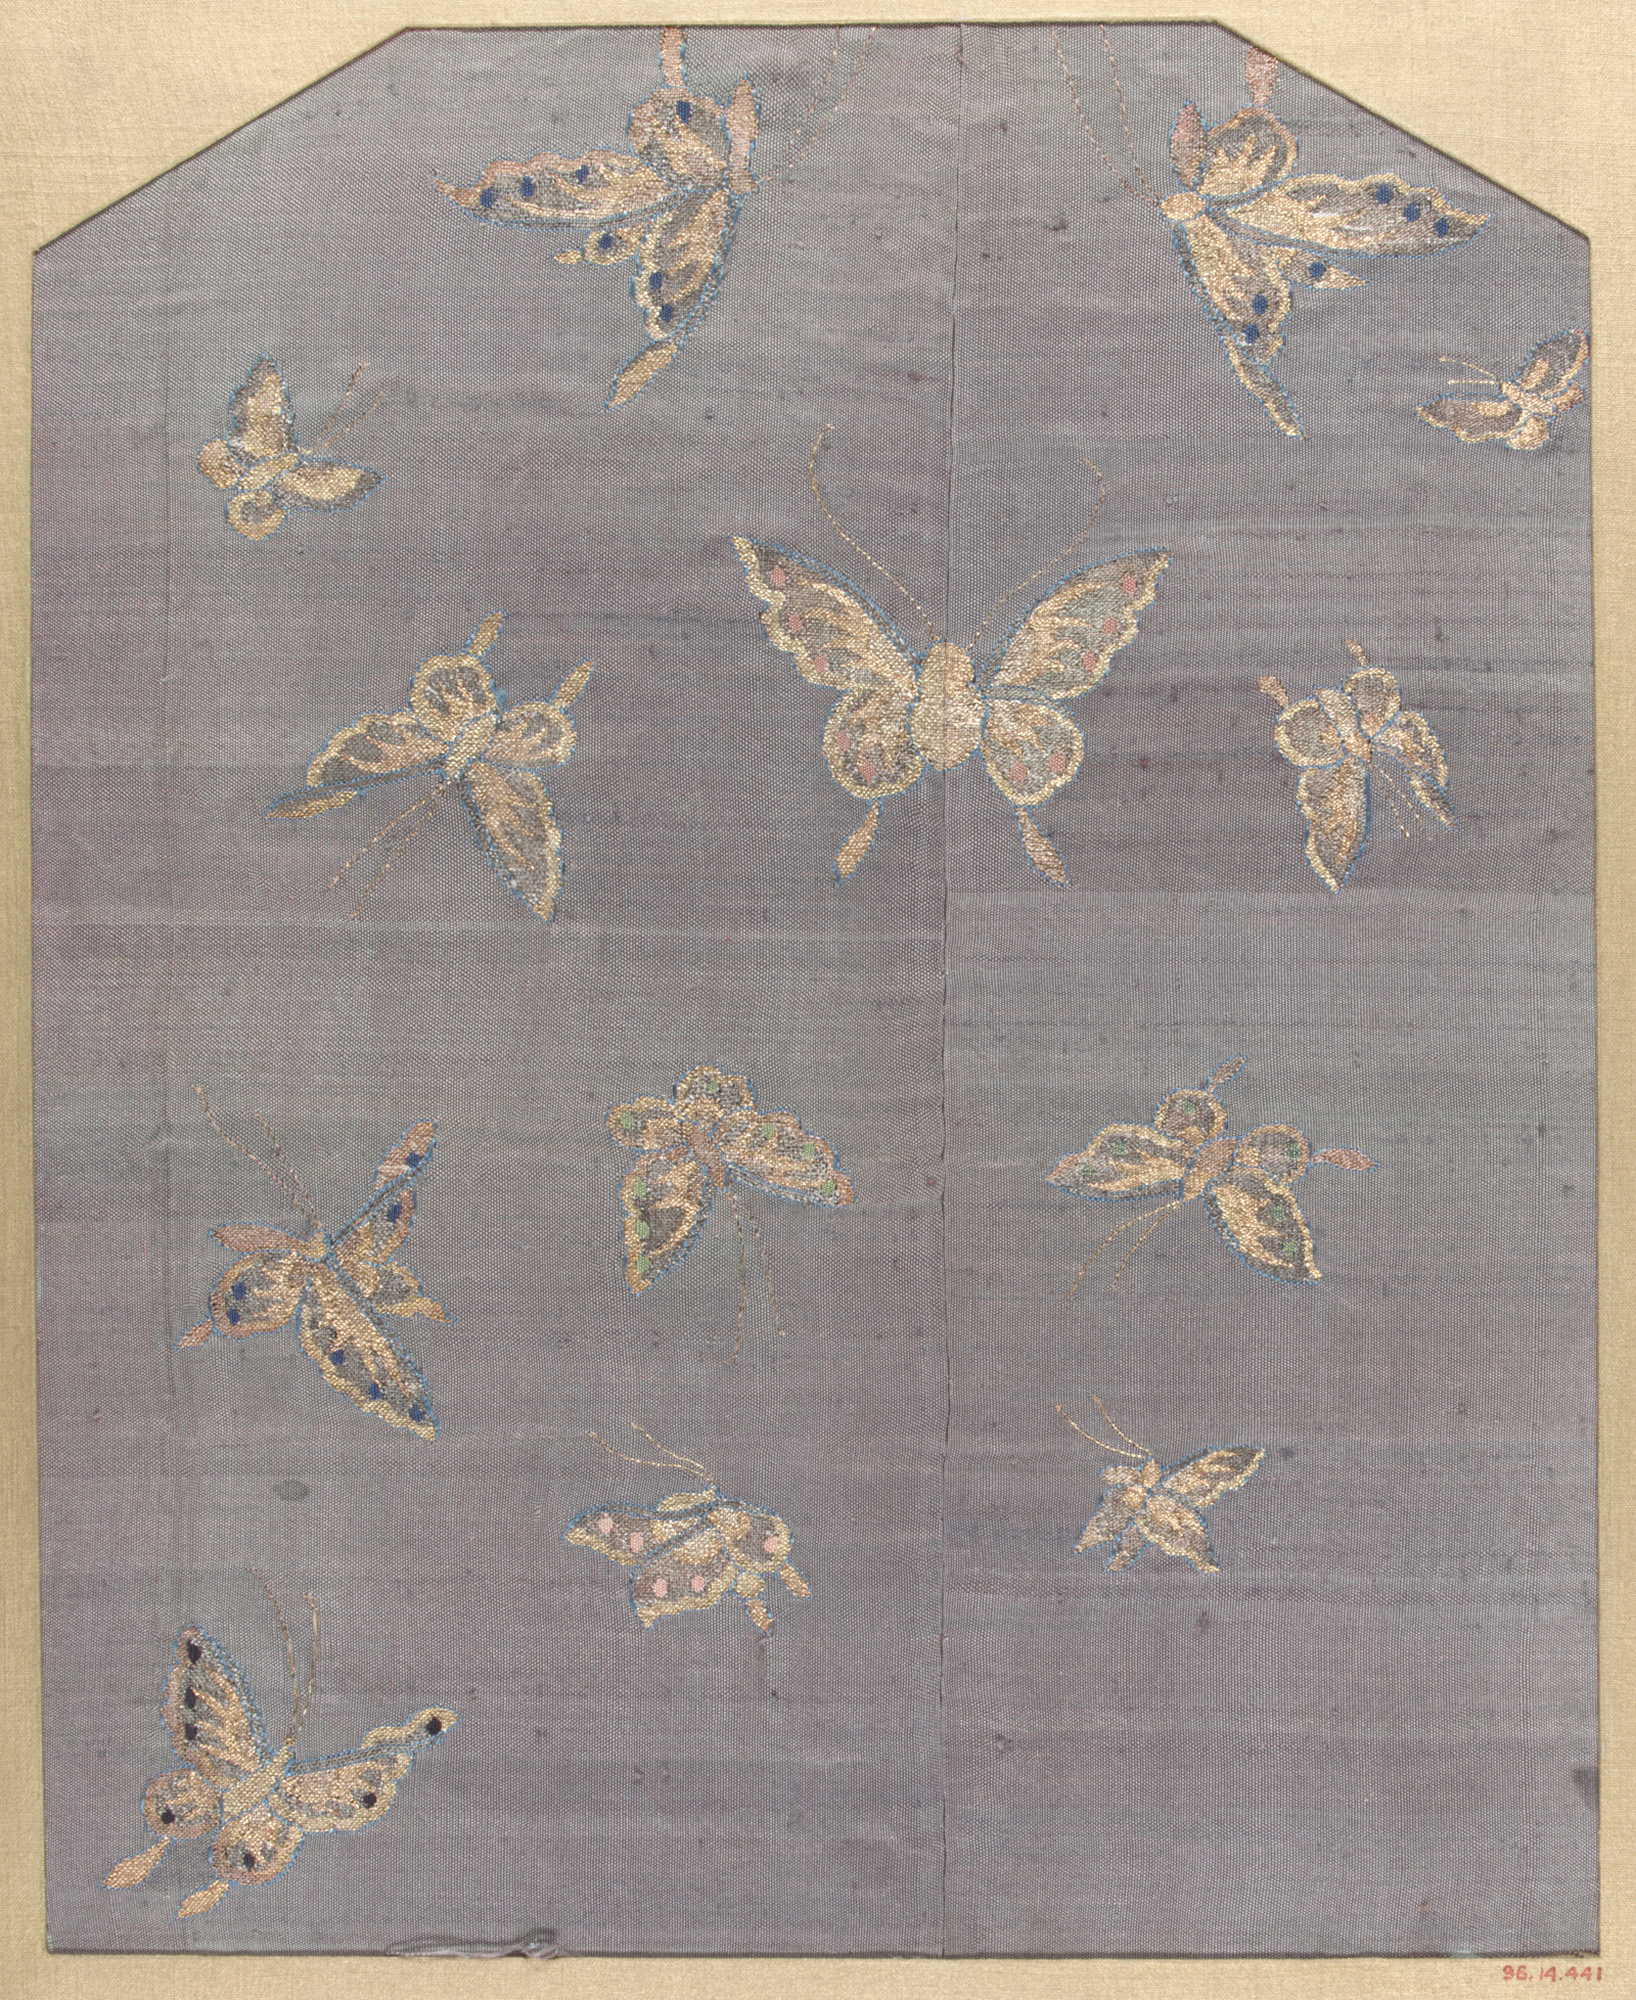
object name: piece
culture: chinese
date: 1701-1900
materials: silk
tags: butterflies